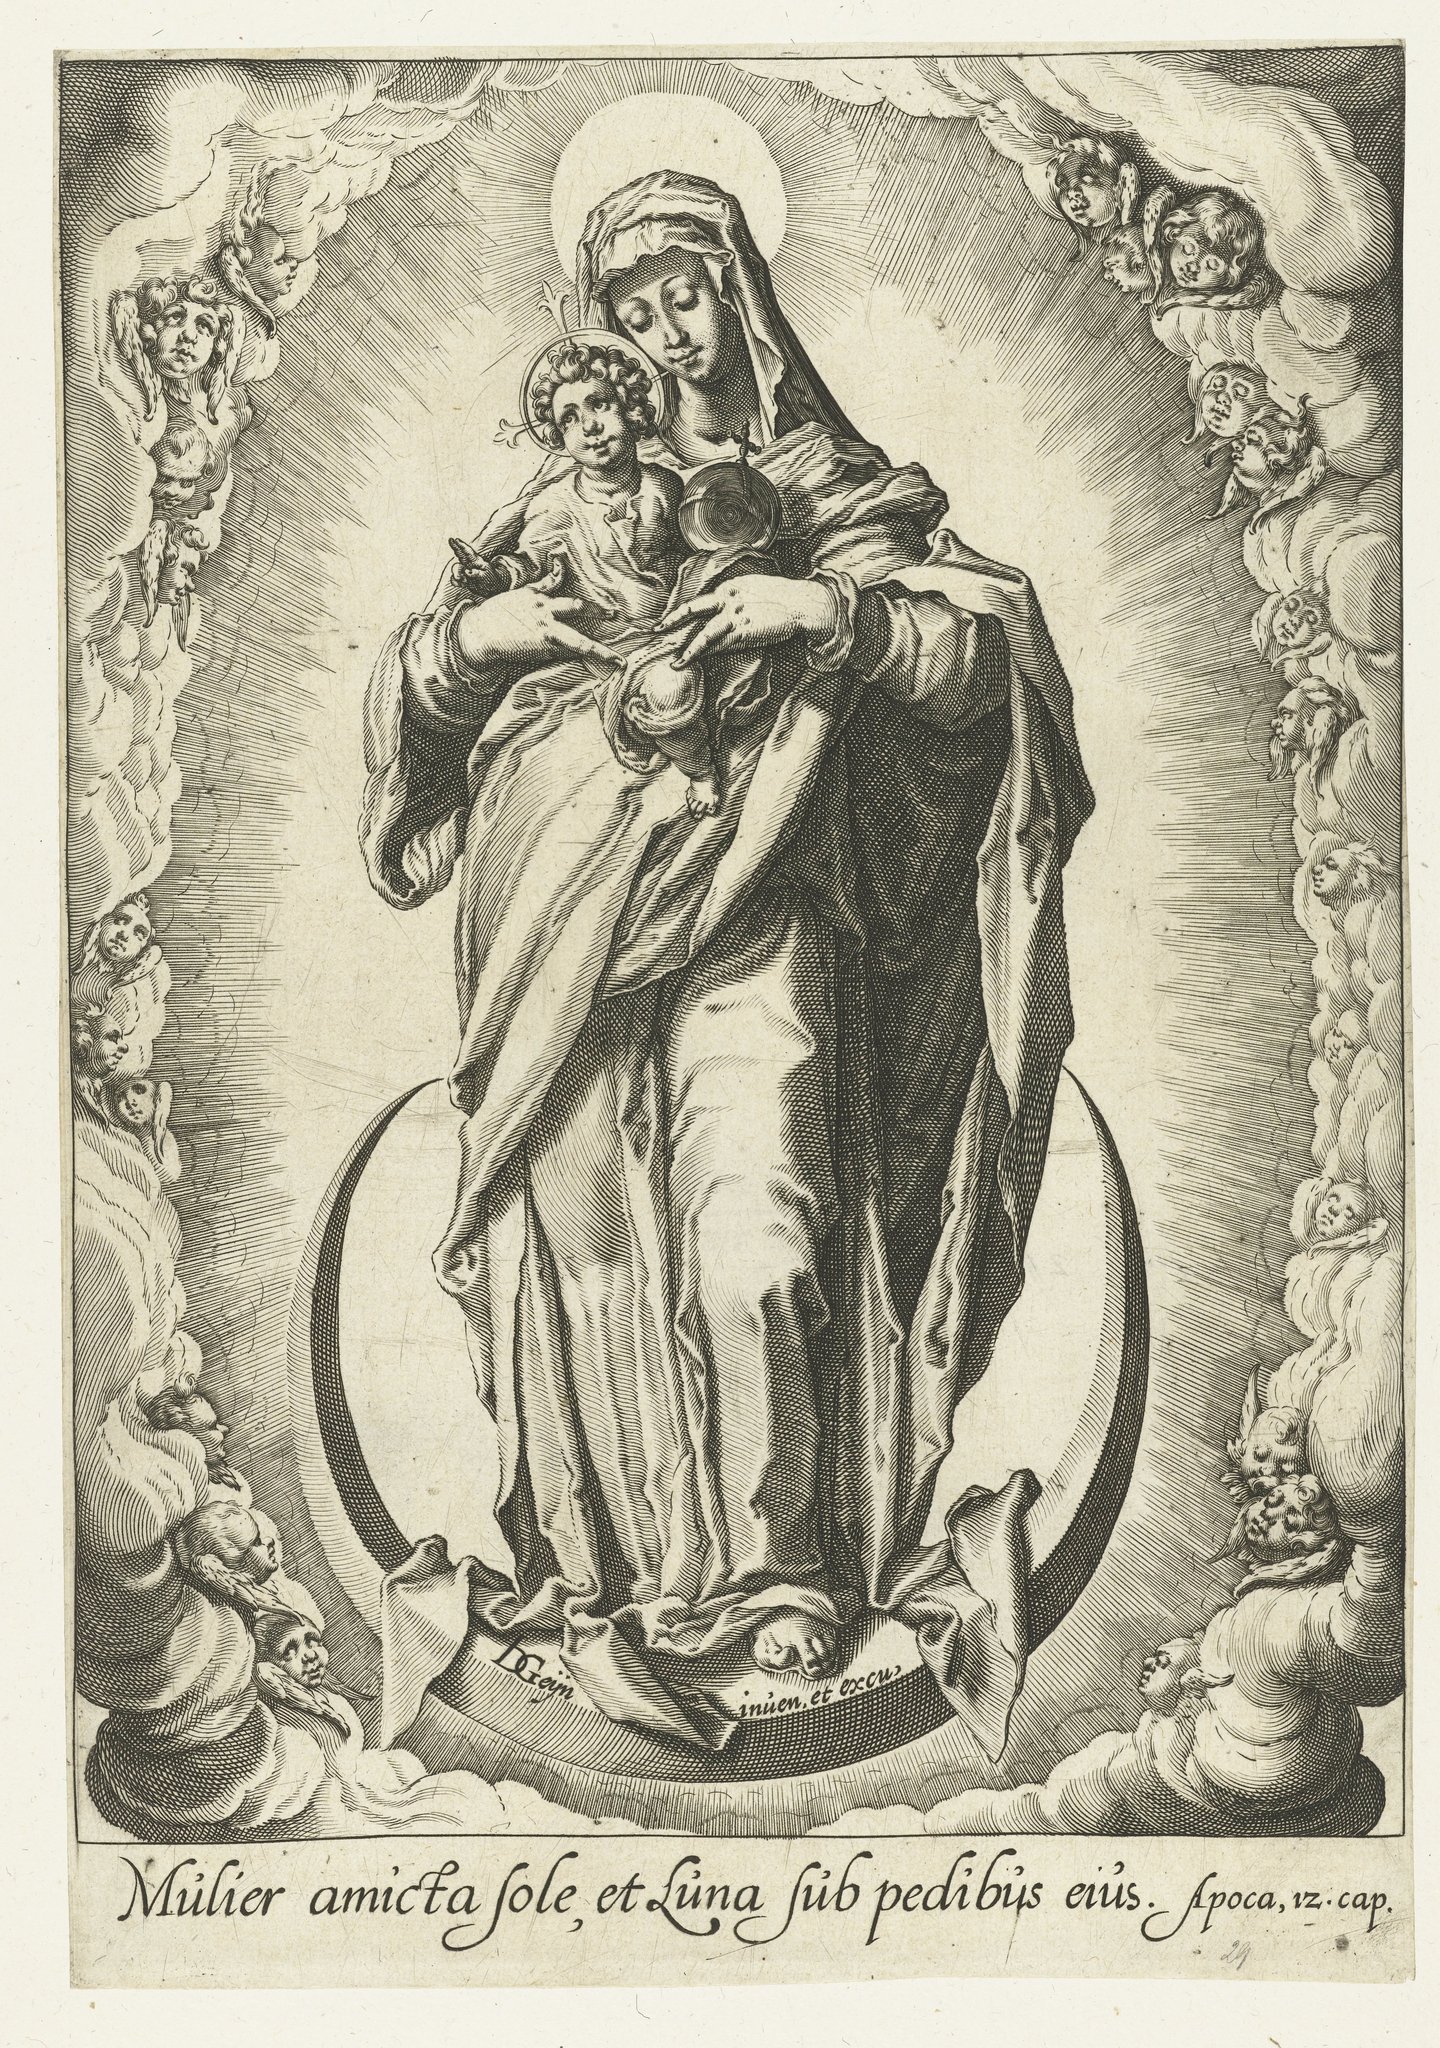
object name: print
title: Maria met Christuskind staand op een maansikkel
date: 1593-1597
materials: paper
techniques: engraving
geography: netherlands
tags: madonna on the crescent of the moon (sometimes called queen of heaven) (in mandorla), madonna (i.e. mary with the christ-child) in the air, or on the clouds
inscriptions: collector's mark: Lugt 2228a, collector's mark: Lugt 2542, inscription: ‘pass 29’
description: Maria, staand op een maansikkel in een krans van wolken en engelen, met het Christuskind (als Salvator Mundi, met rijksappel) op de arm. Onder de voorstelling een regel Latijnse tekst (Openbaring 12).